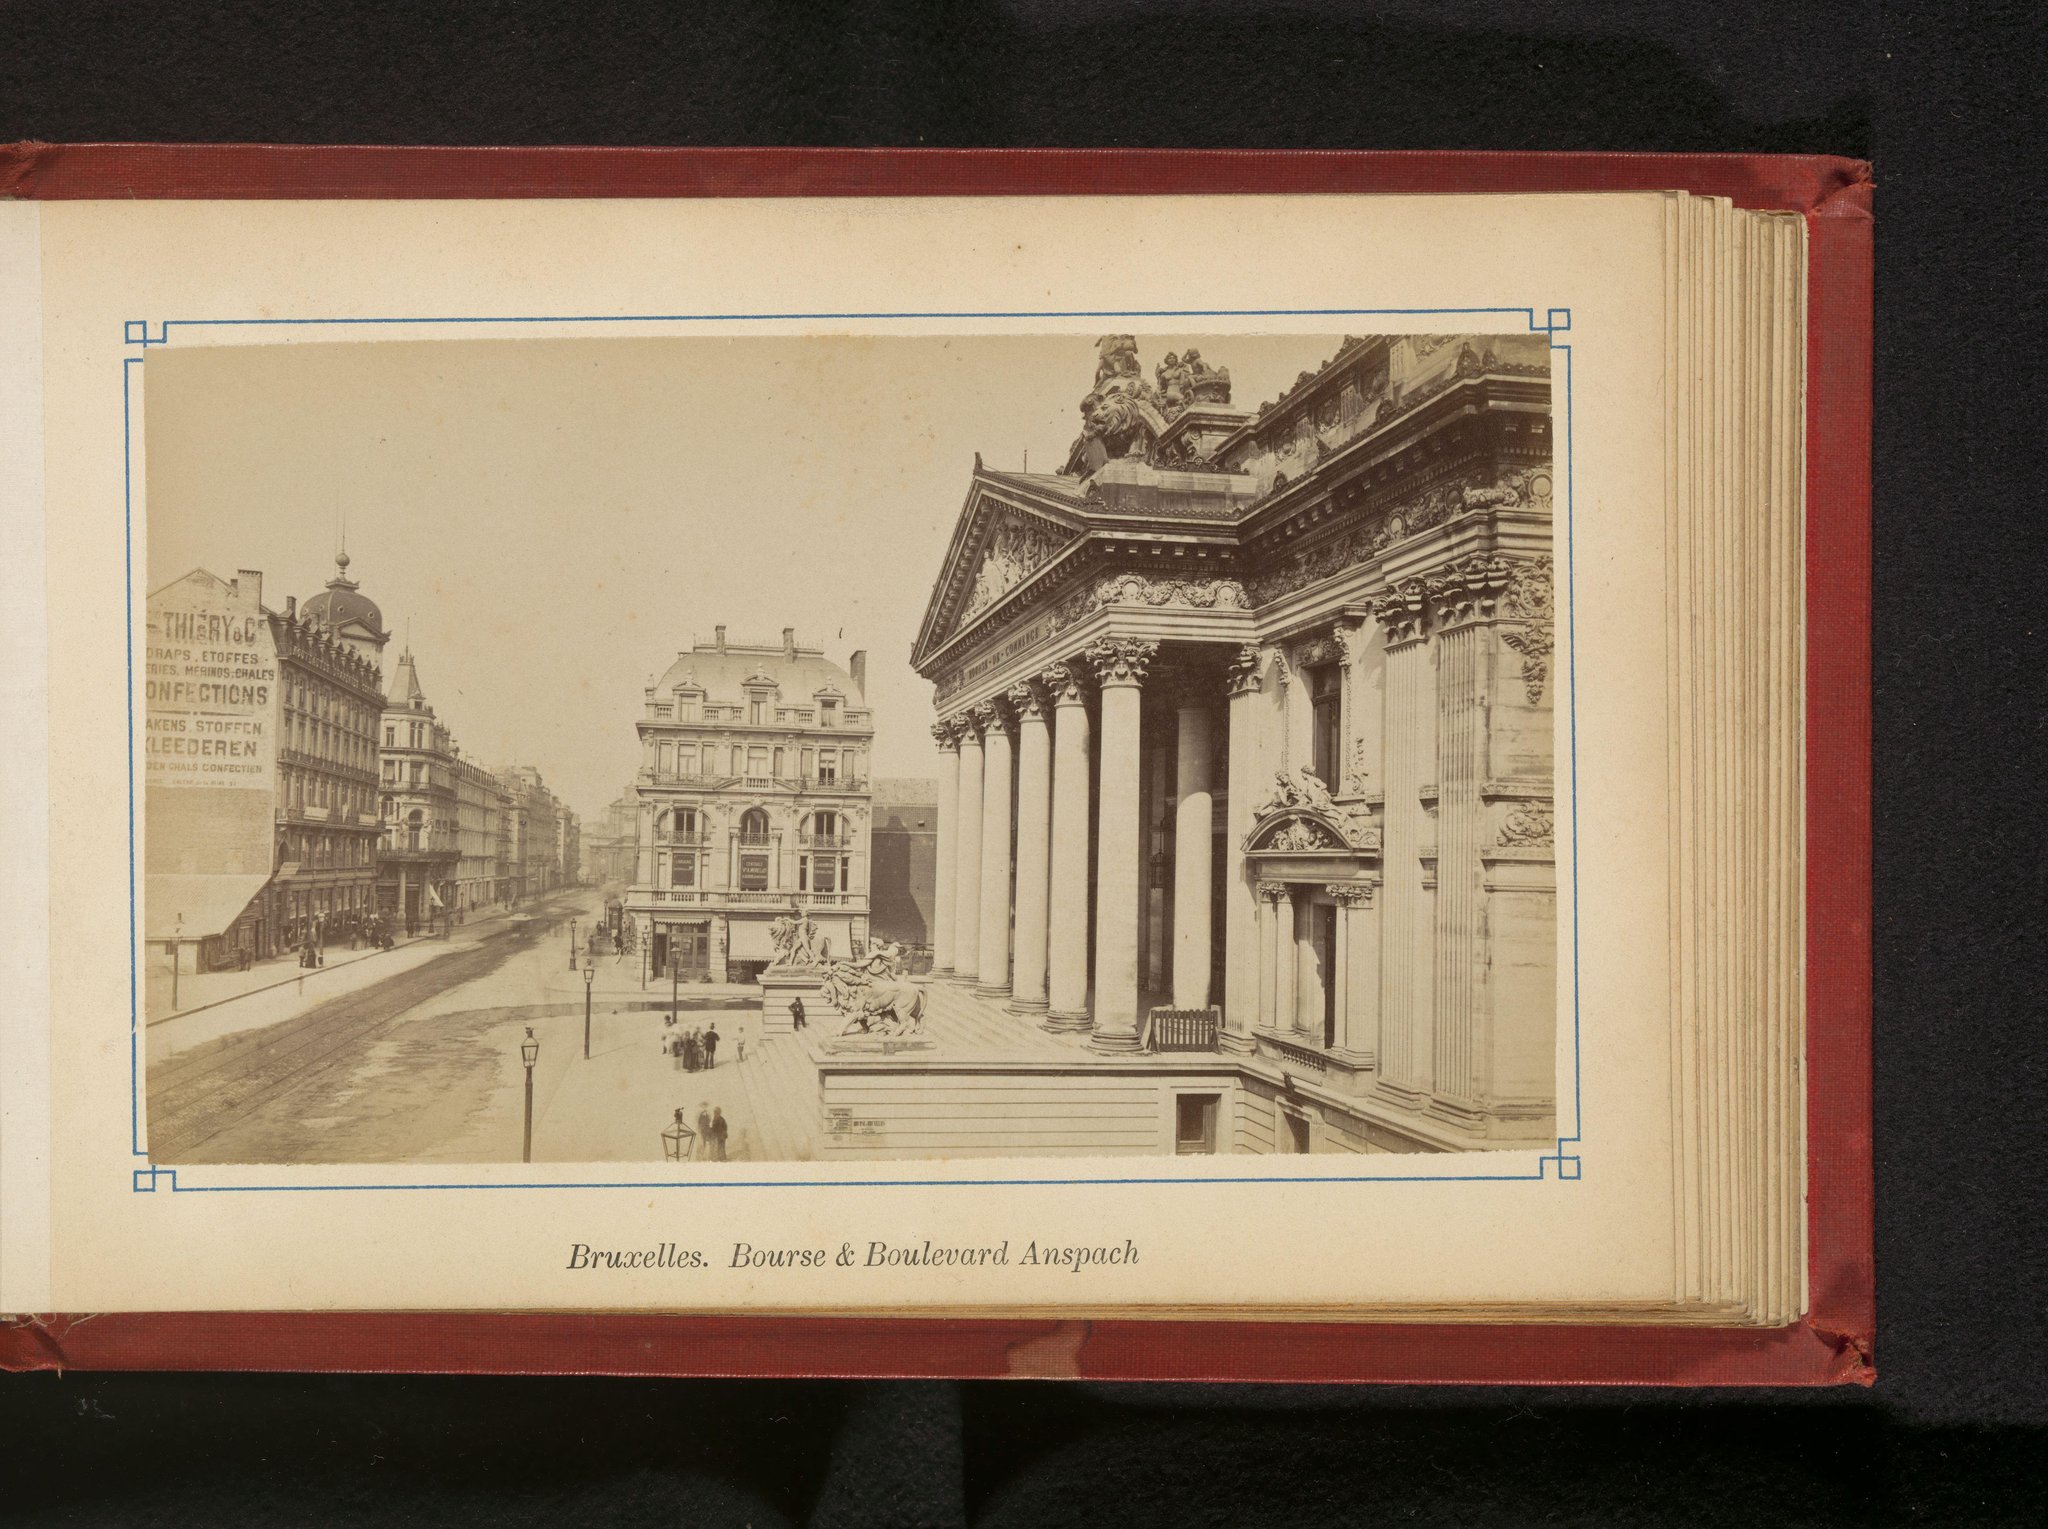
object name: page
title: Gezicht op de Anspachlaan en de beurs te Brussel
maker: Anonymous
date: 1875-1880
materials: photographic support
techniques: albumen print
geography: boulevard anspach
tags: avenue, boulevard, promenade, esplanade (+ city(-scape) with figures, staffage), exchange, bourse